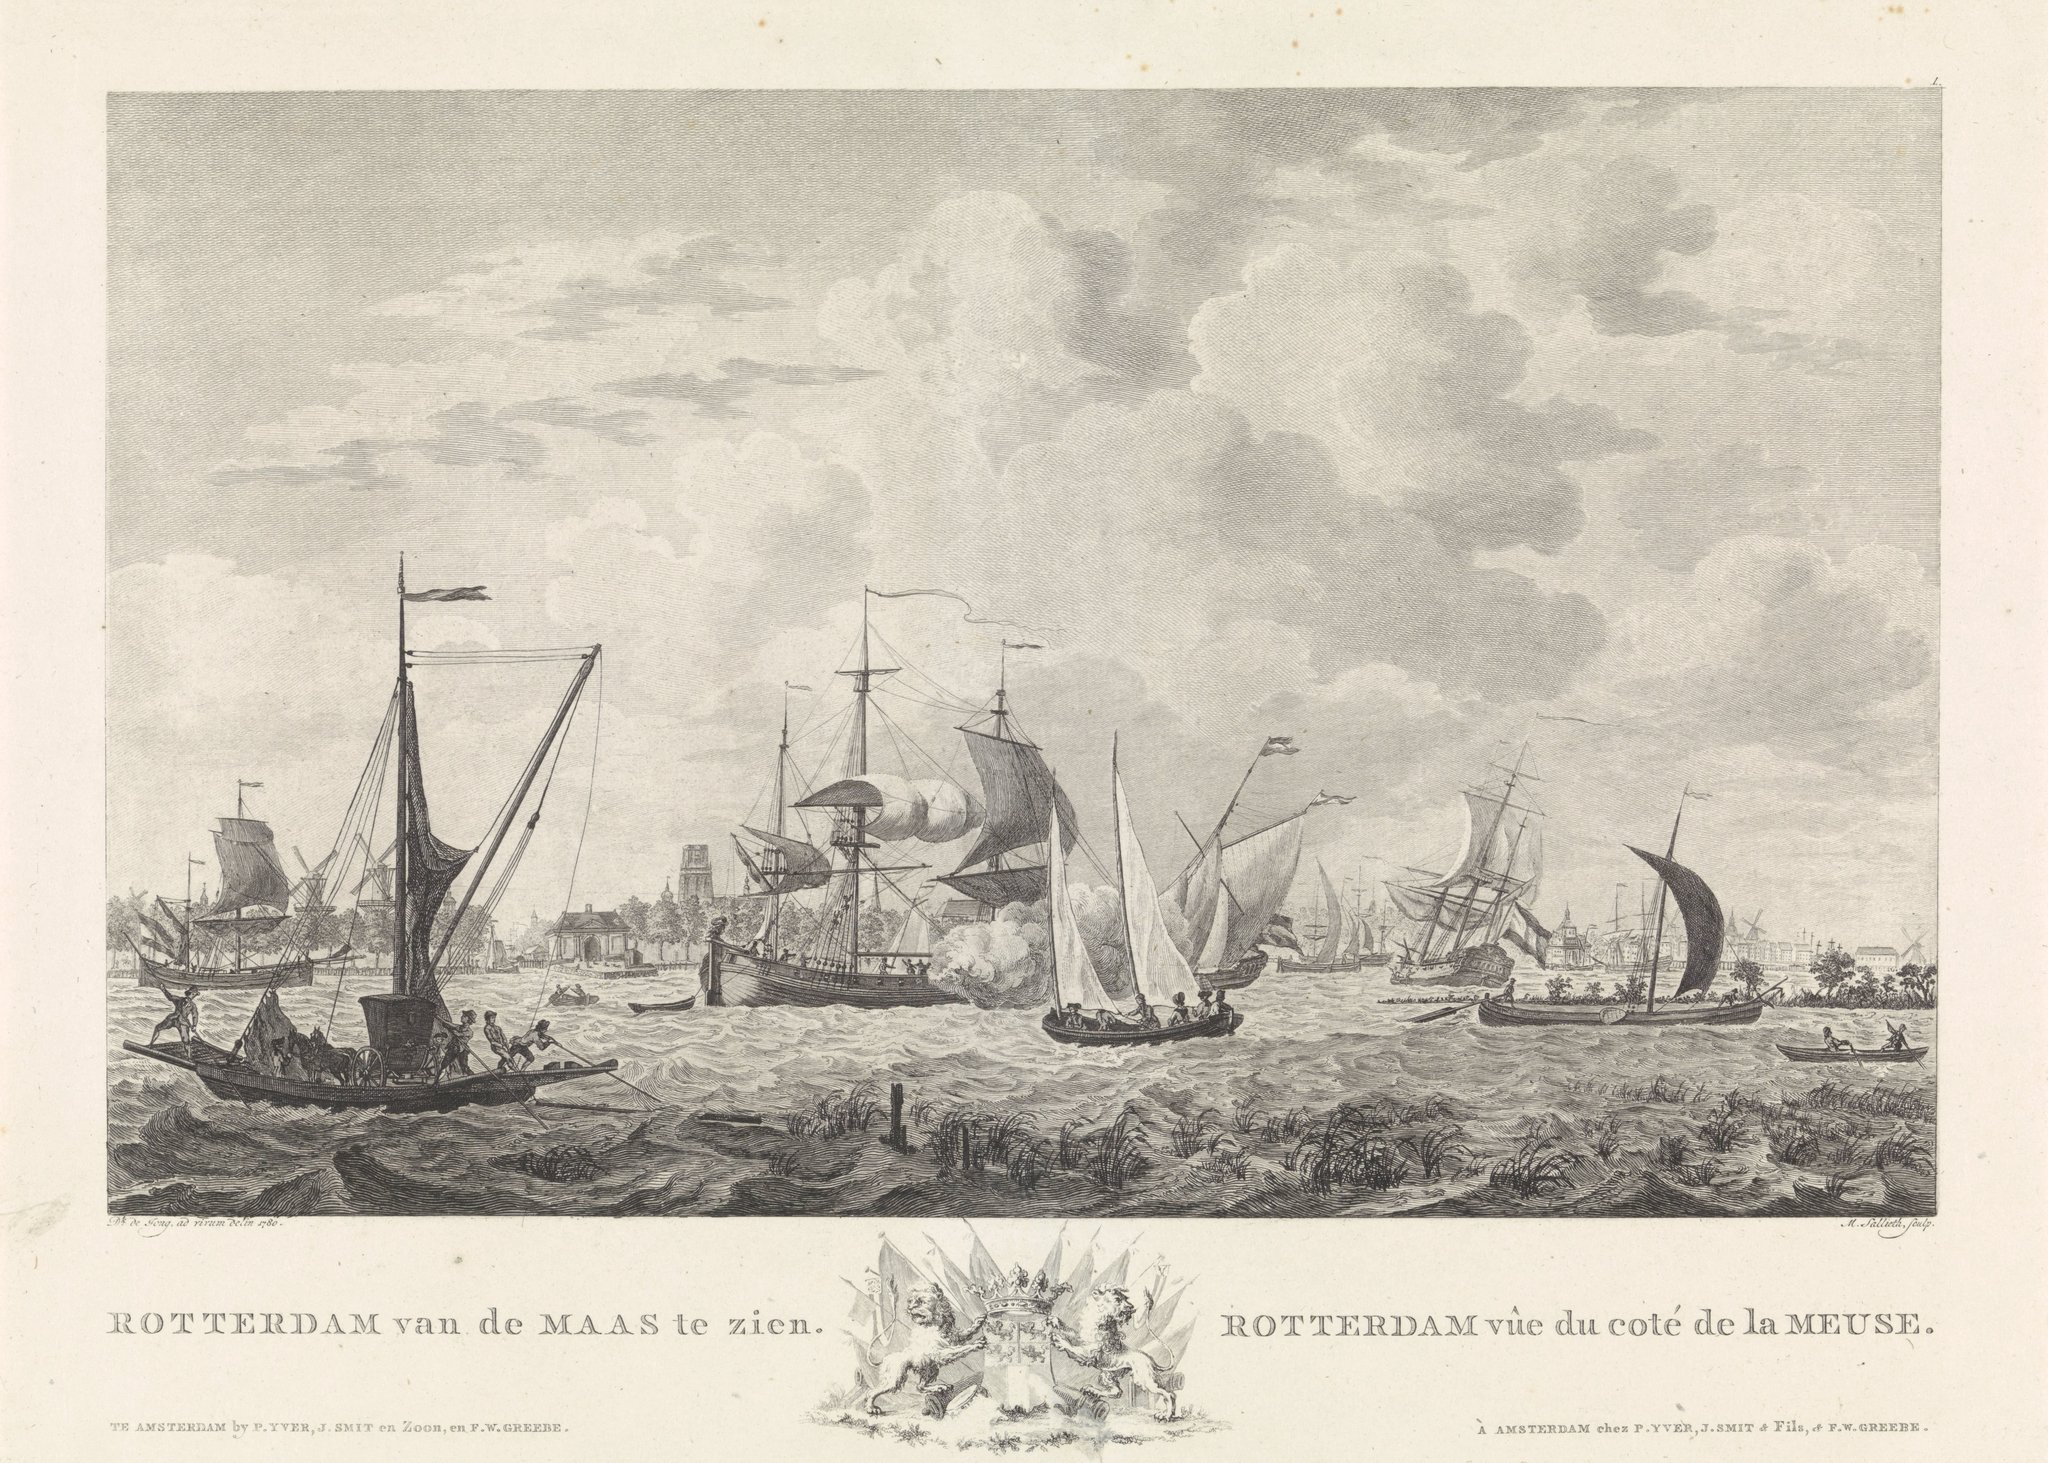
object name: print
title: Rotterdam van de Maas te zien / Rotterdam vûe du coté de la Meuse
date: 1780-1787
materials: paper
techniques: etching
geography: amsterdam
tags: coat of arms (as symbol of the state, etc.) (+ city; municipal), sailing-ship, sailing-boat, landscapes with waters, waterscapes, seascapes (in the temperate zone), rotterdam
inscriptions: collector's mark: Lugt 2233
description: Gezicht op Rotterdam, gezien vanaf de Maas. In de marge het wapen van de stad. Prent rechtsboven genummerd: 1.